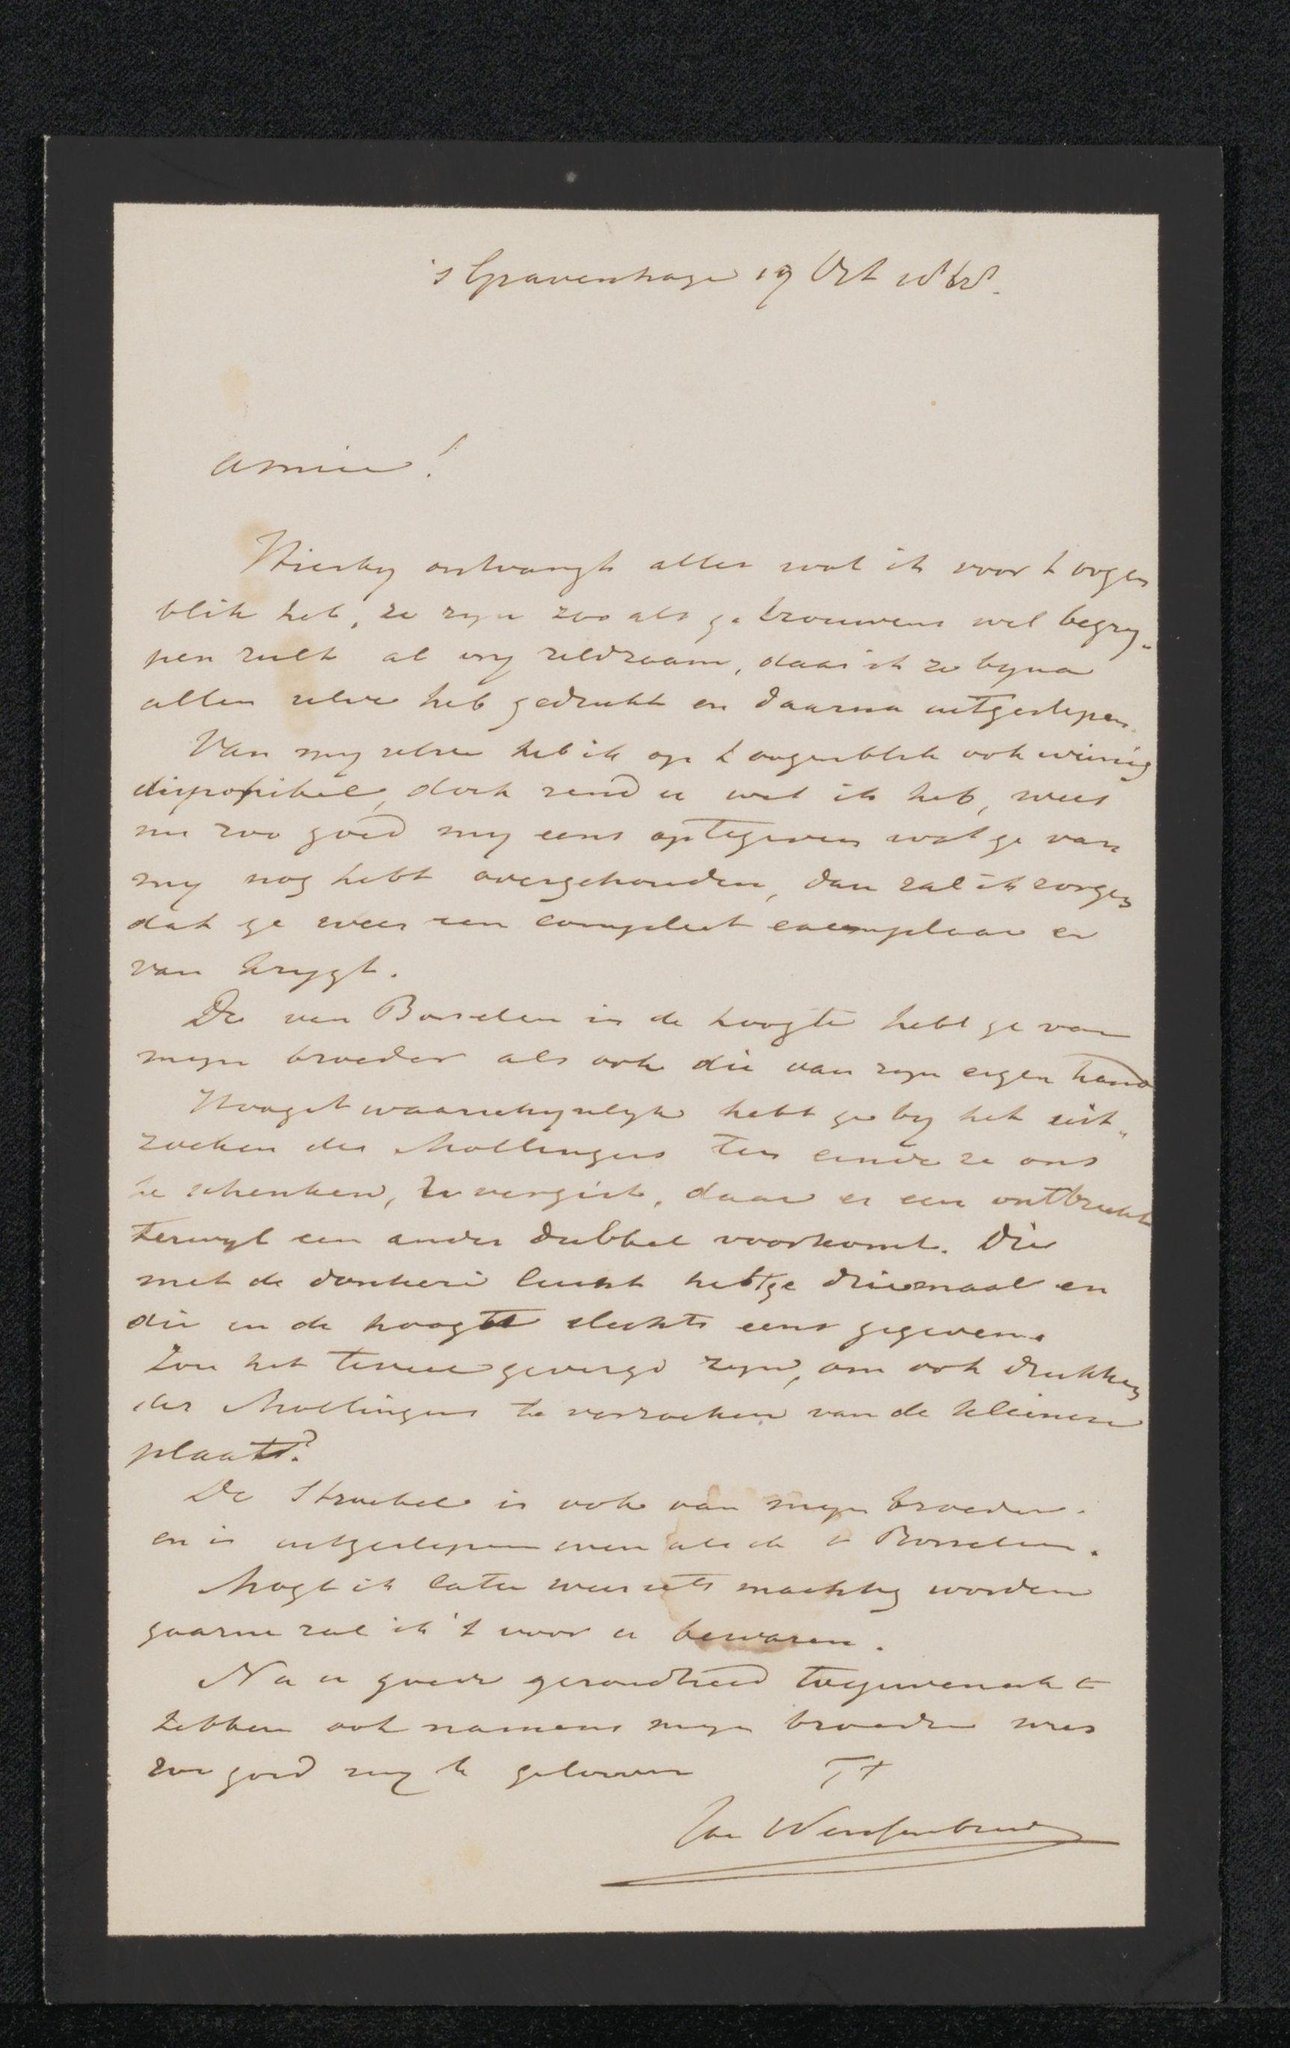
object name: letter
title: Brief aan anoniem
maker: jan weissenbruch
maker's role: painter, print maker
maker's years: 1822-1880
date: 1868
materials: ink, paper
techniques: pen, writing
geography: the hague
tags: the graphic arts